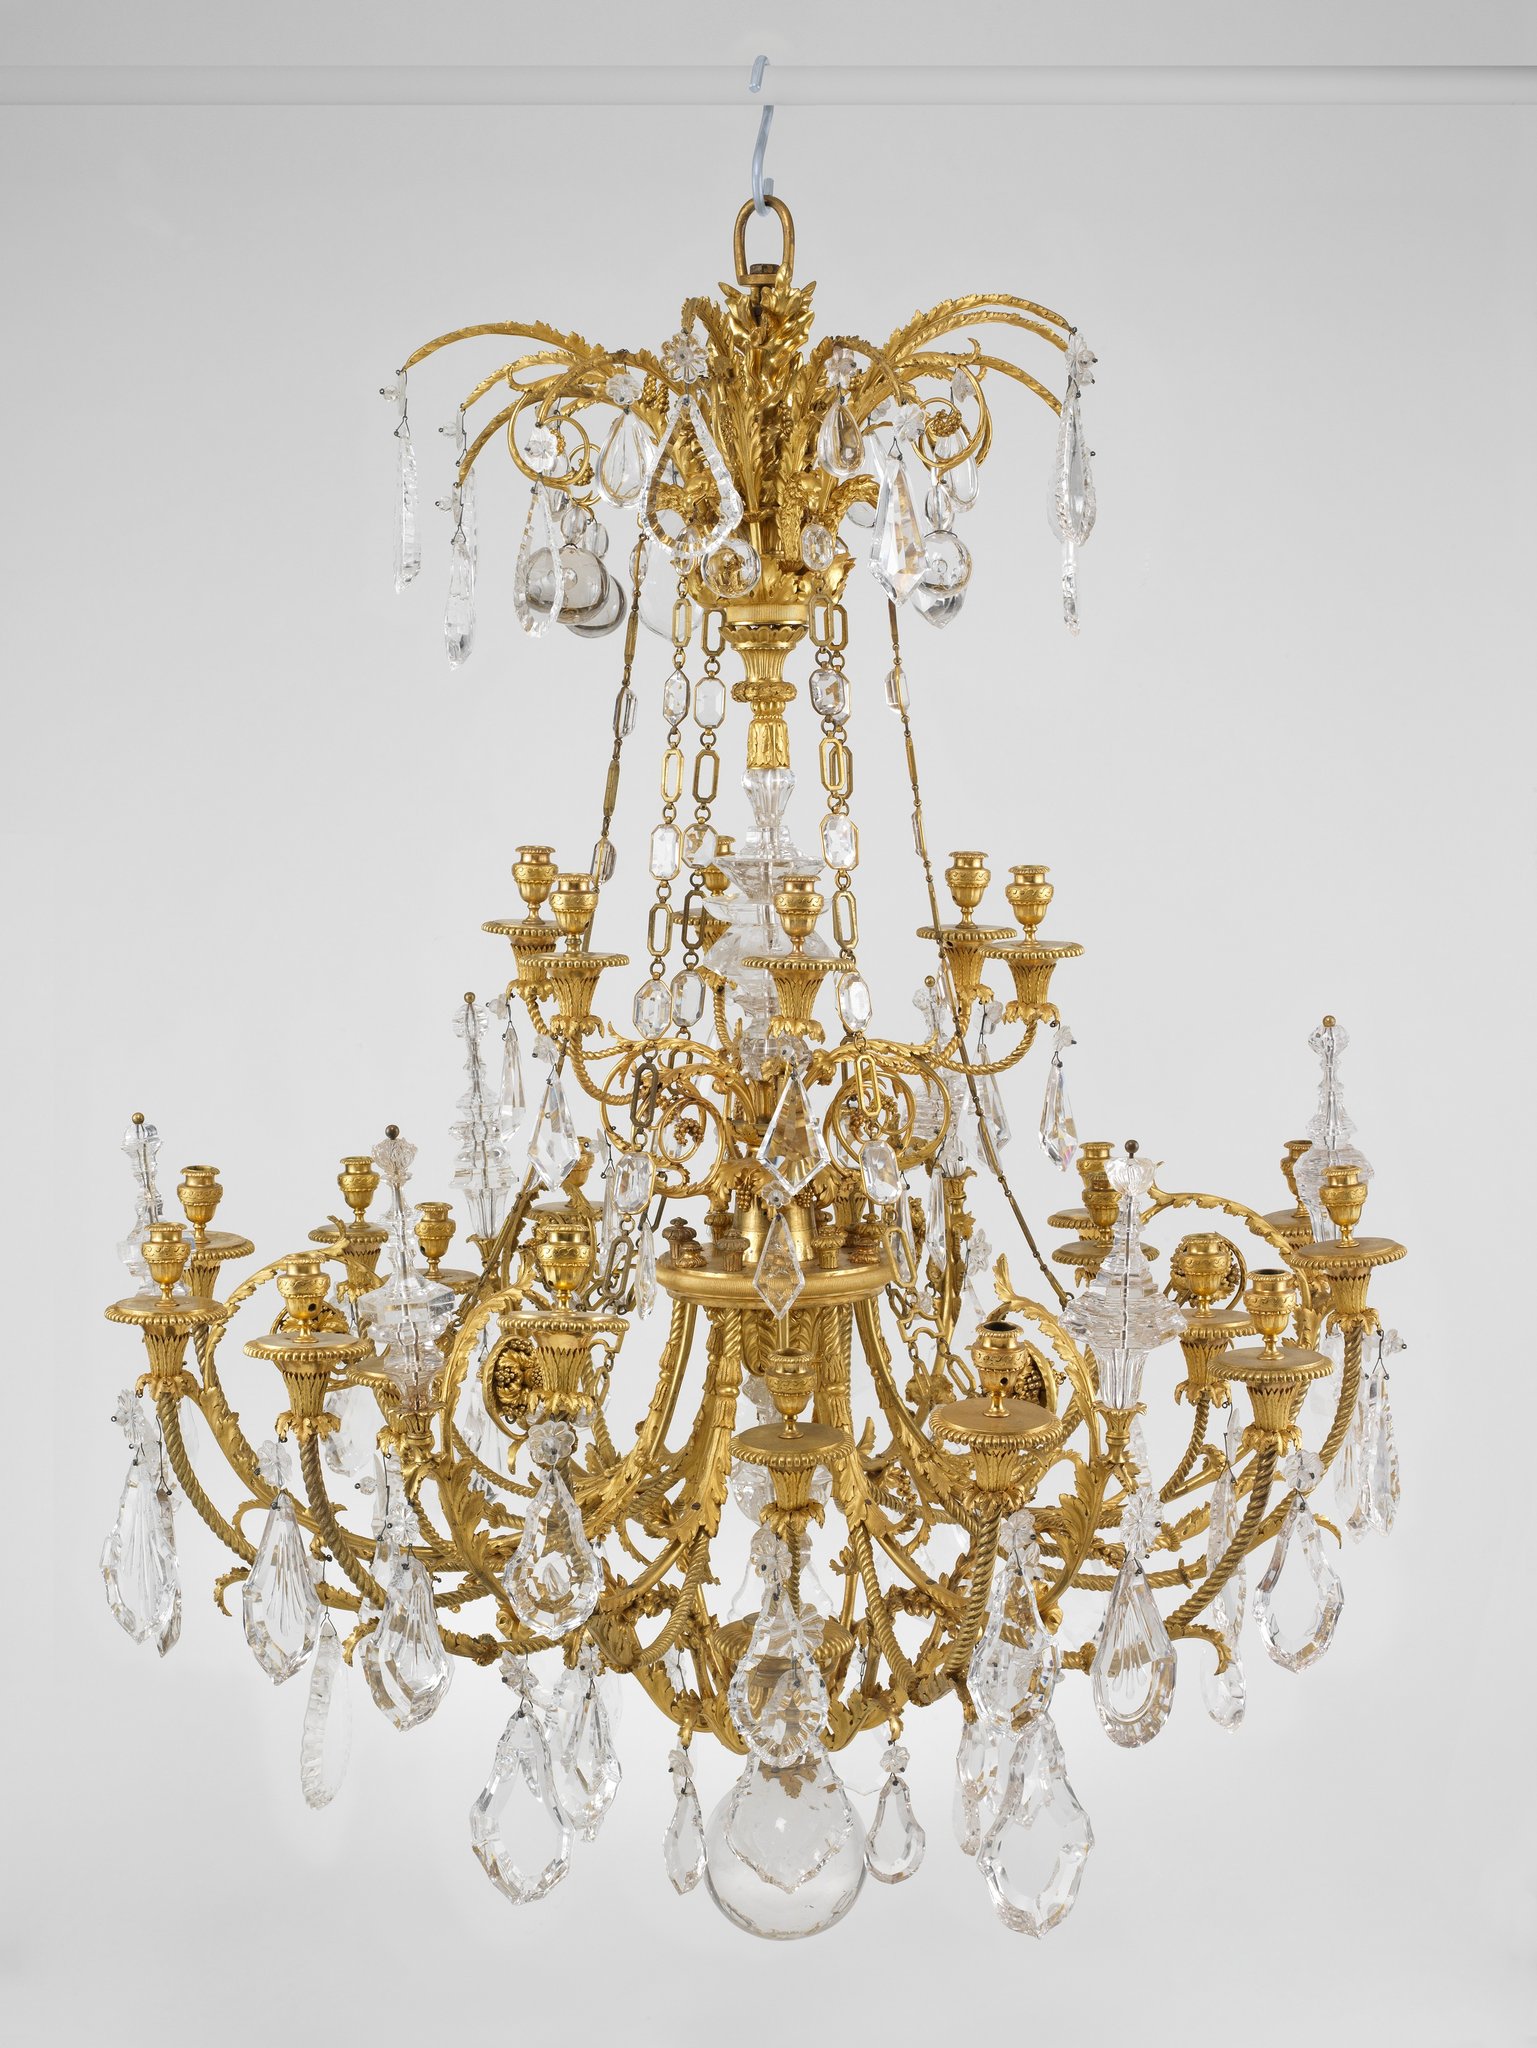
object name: chandelier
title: Twenty-four-light chandelier (lustre) (one of a pair)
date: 1790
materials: gilt bronze, quartz